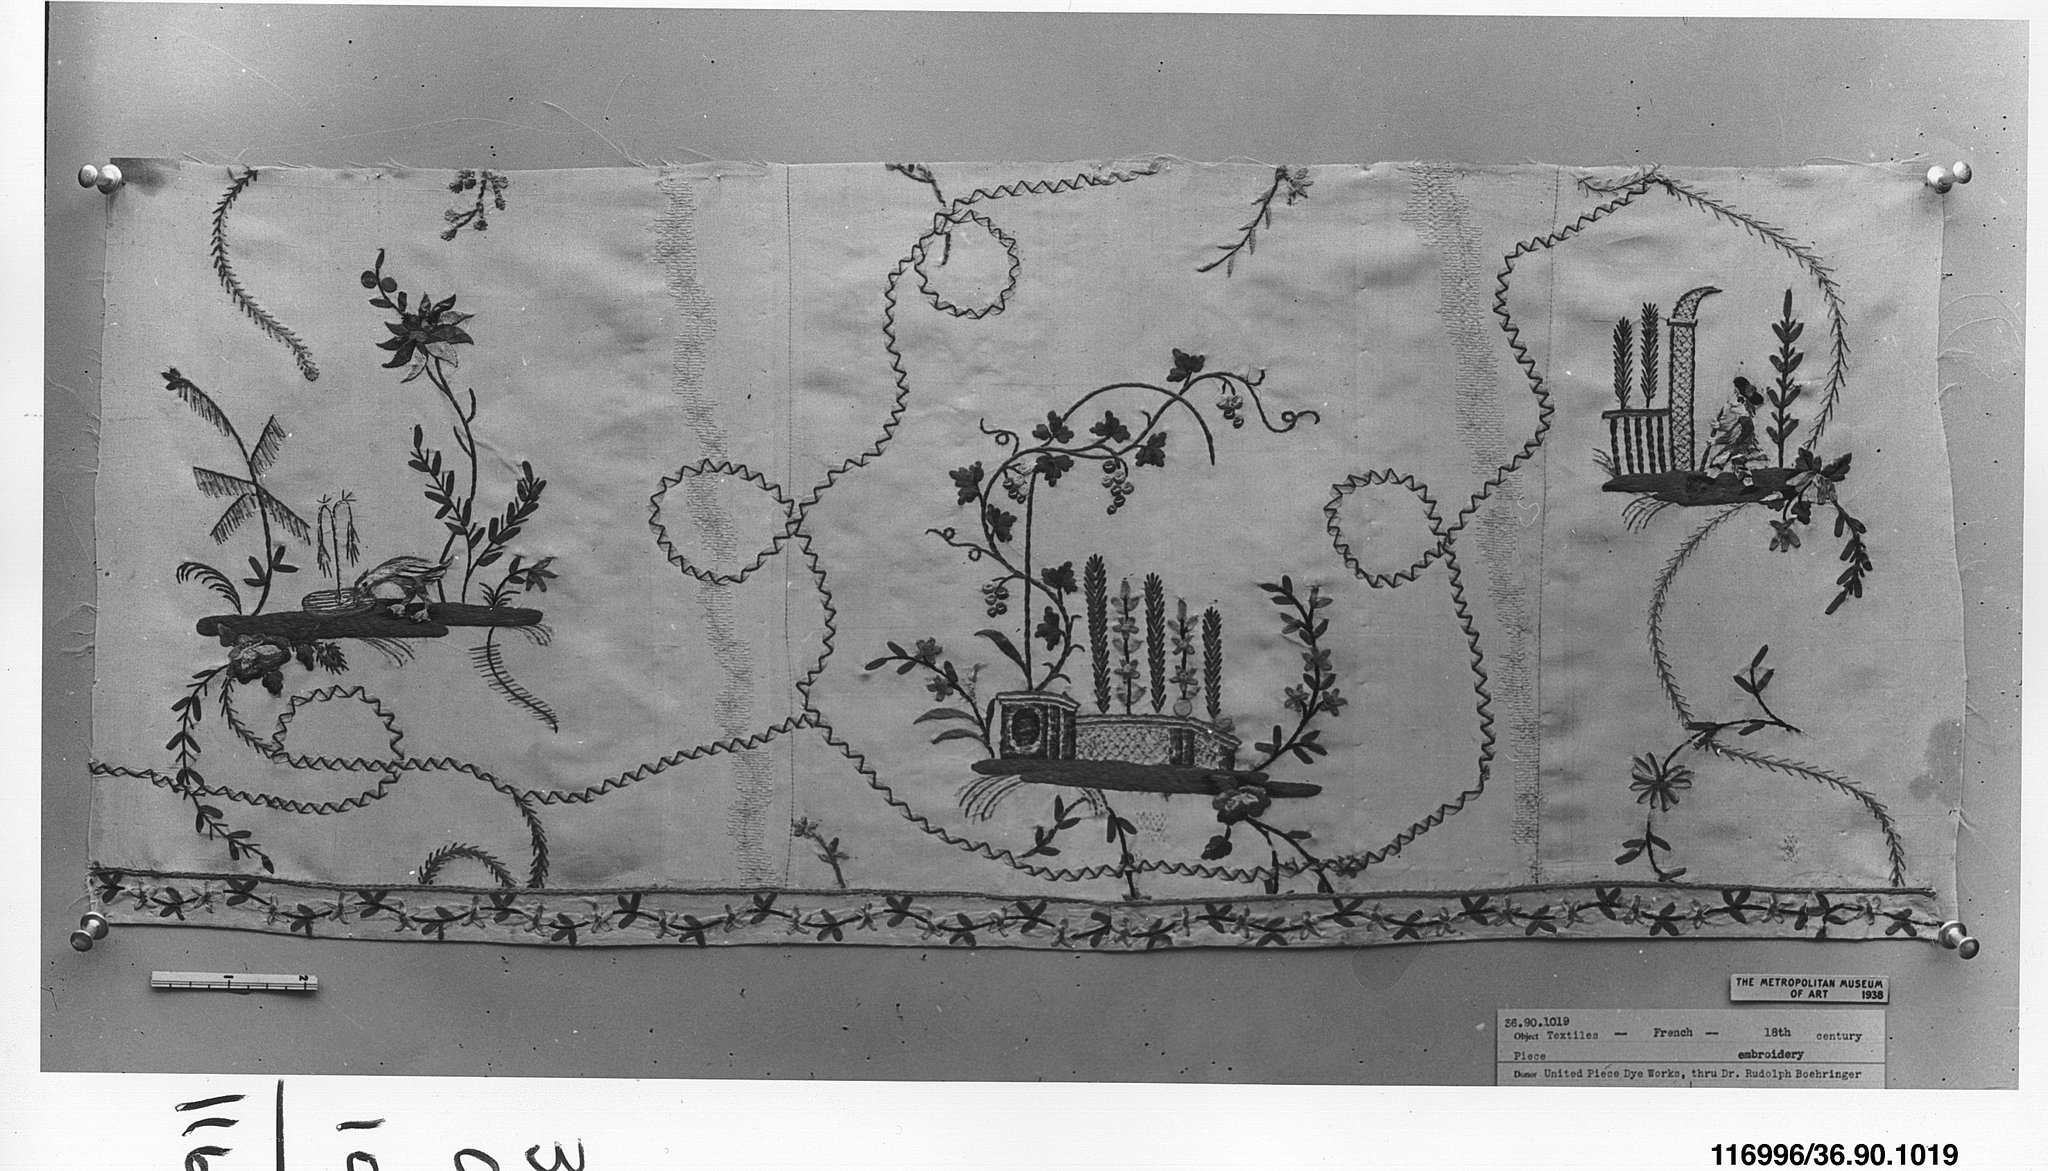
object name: piece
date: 1767-1800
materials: silk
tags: leaves